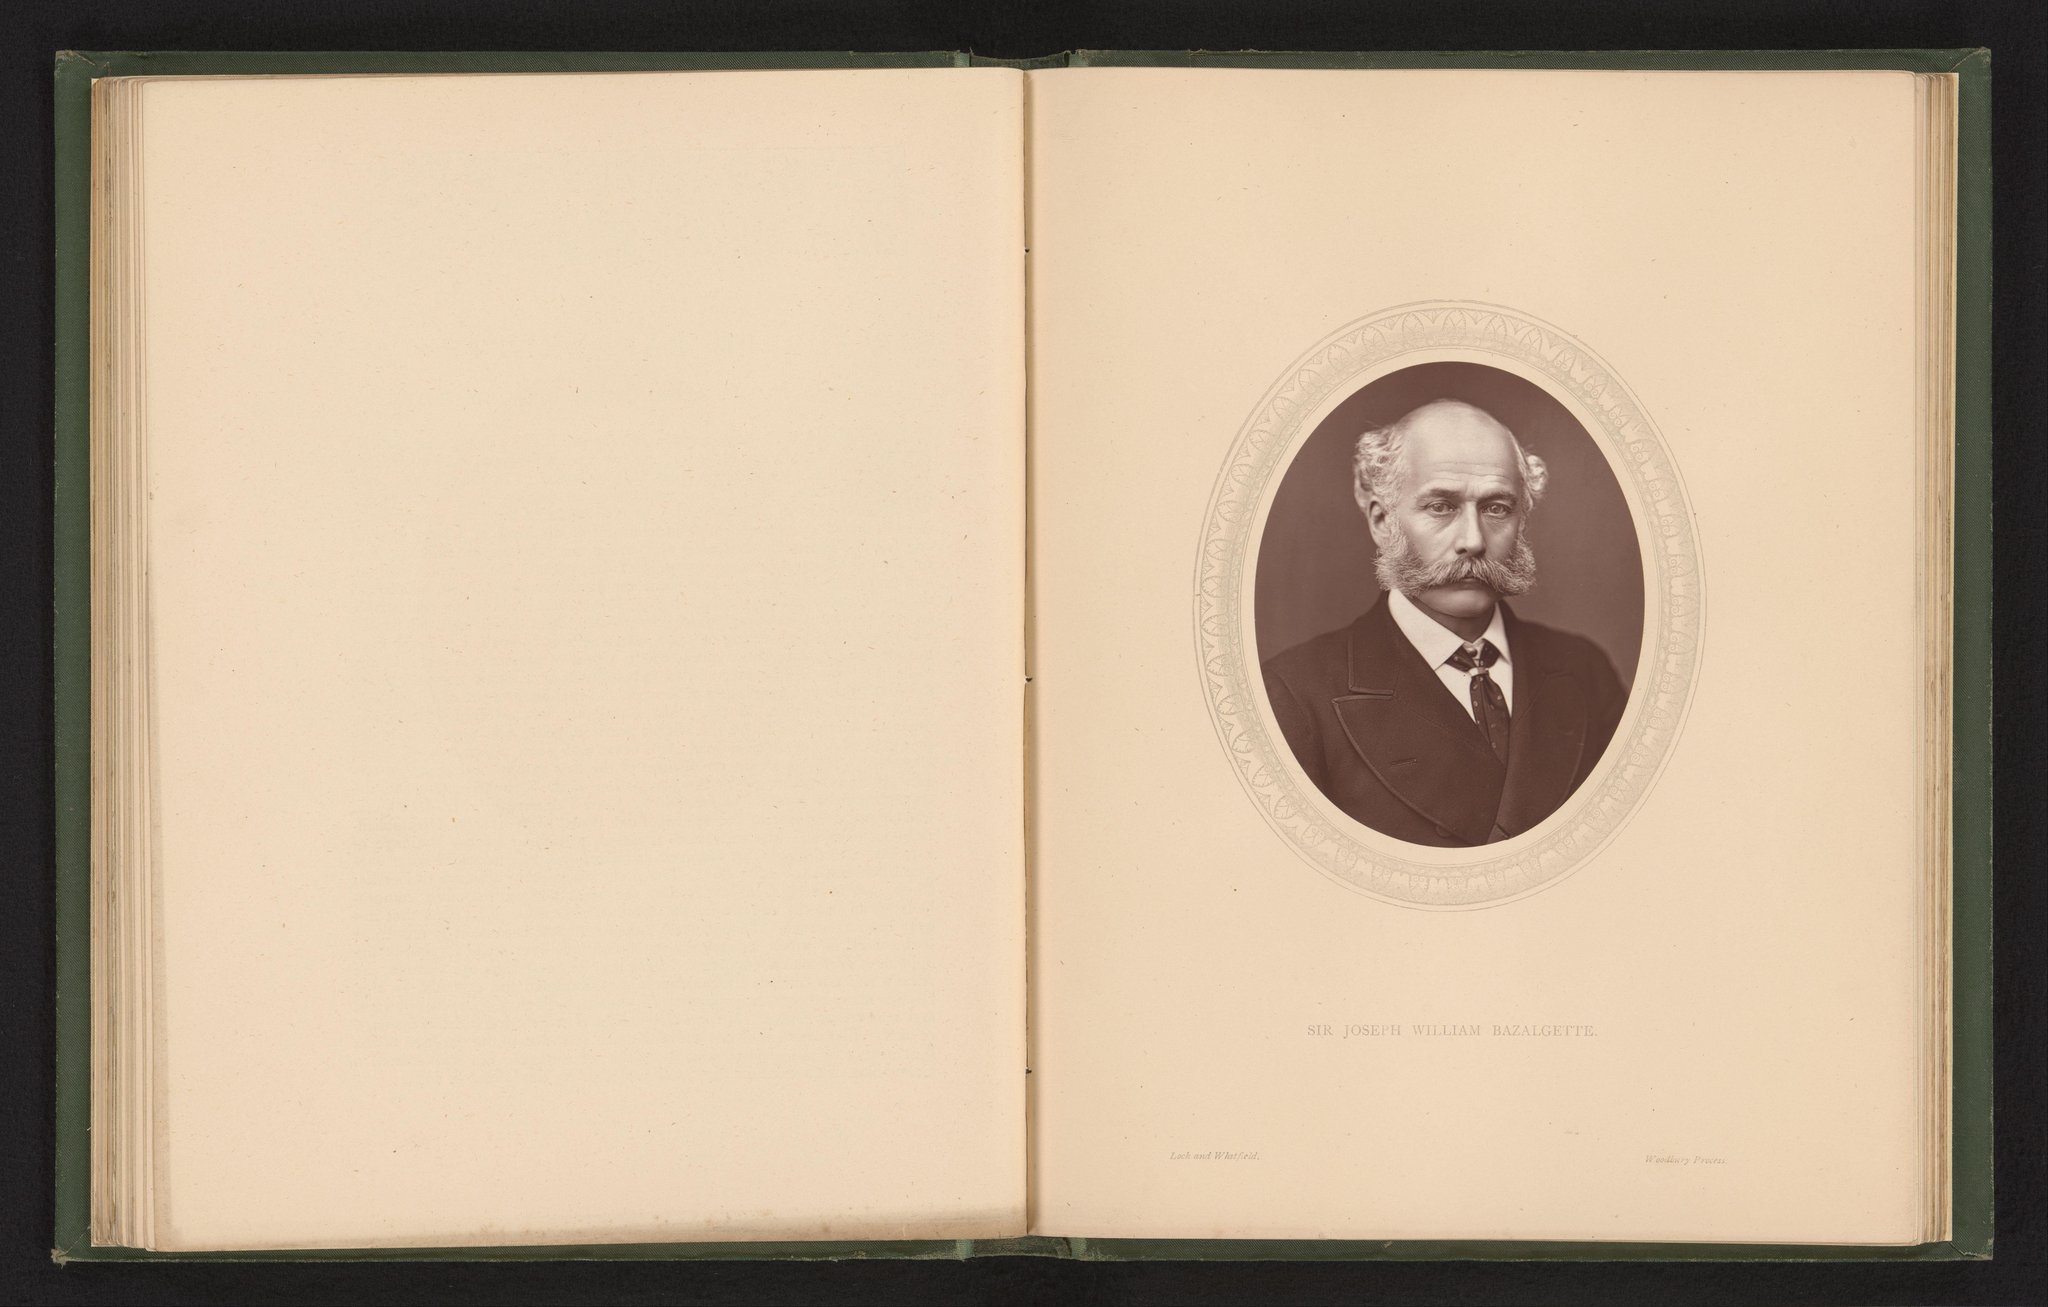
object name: page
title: Sir Joseph William Bazalgette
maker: Anonymous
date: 1872-1877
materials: paper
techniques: woodburytype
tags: engineer, engineering, historical persons (portraits and scenes from the life) (+ (full) bust portrait)